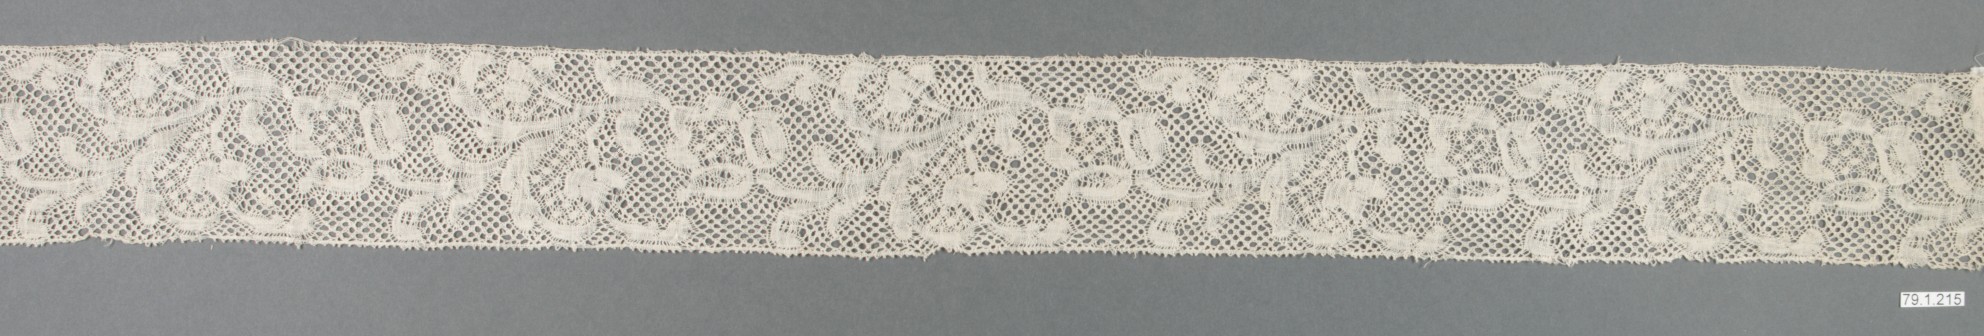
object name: insertion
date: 1701-1800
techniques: lace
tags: flowers